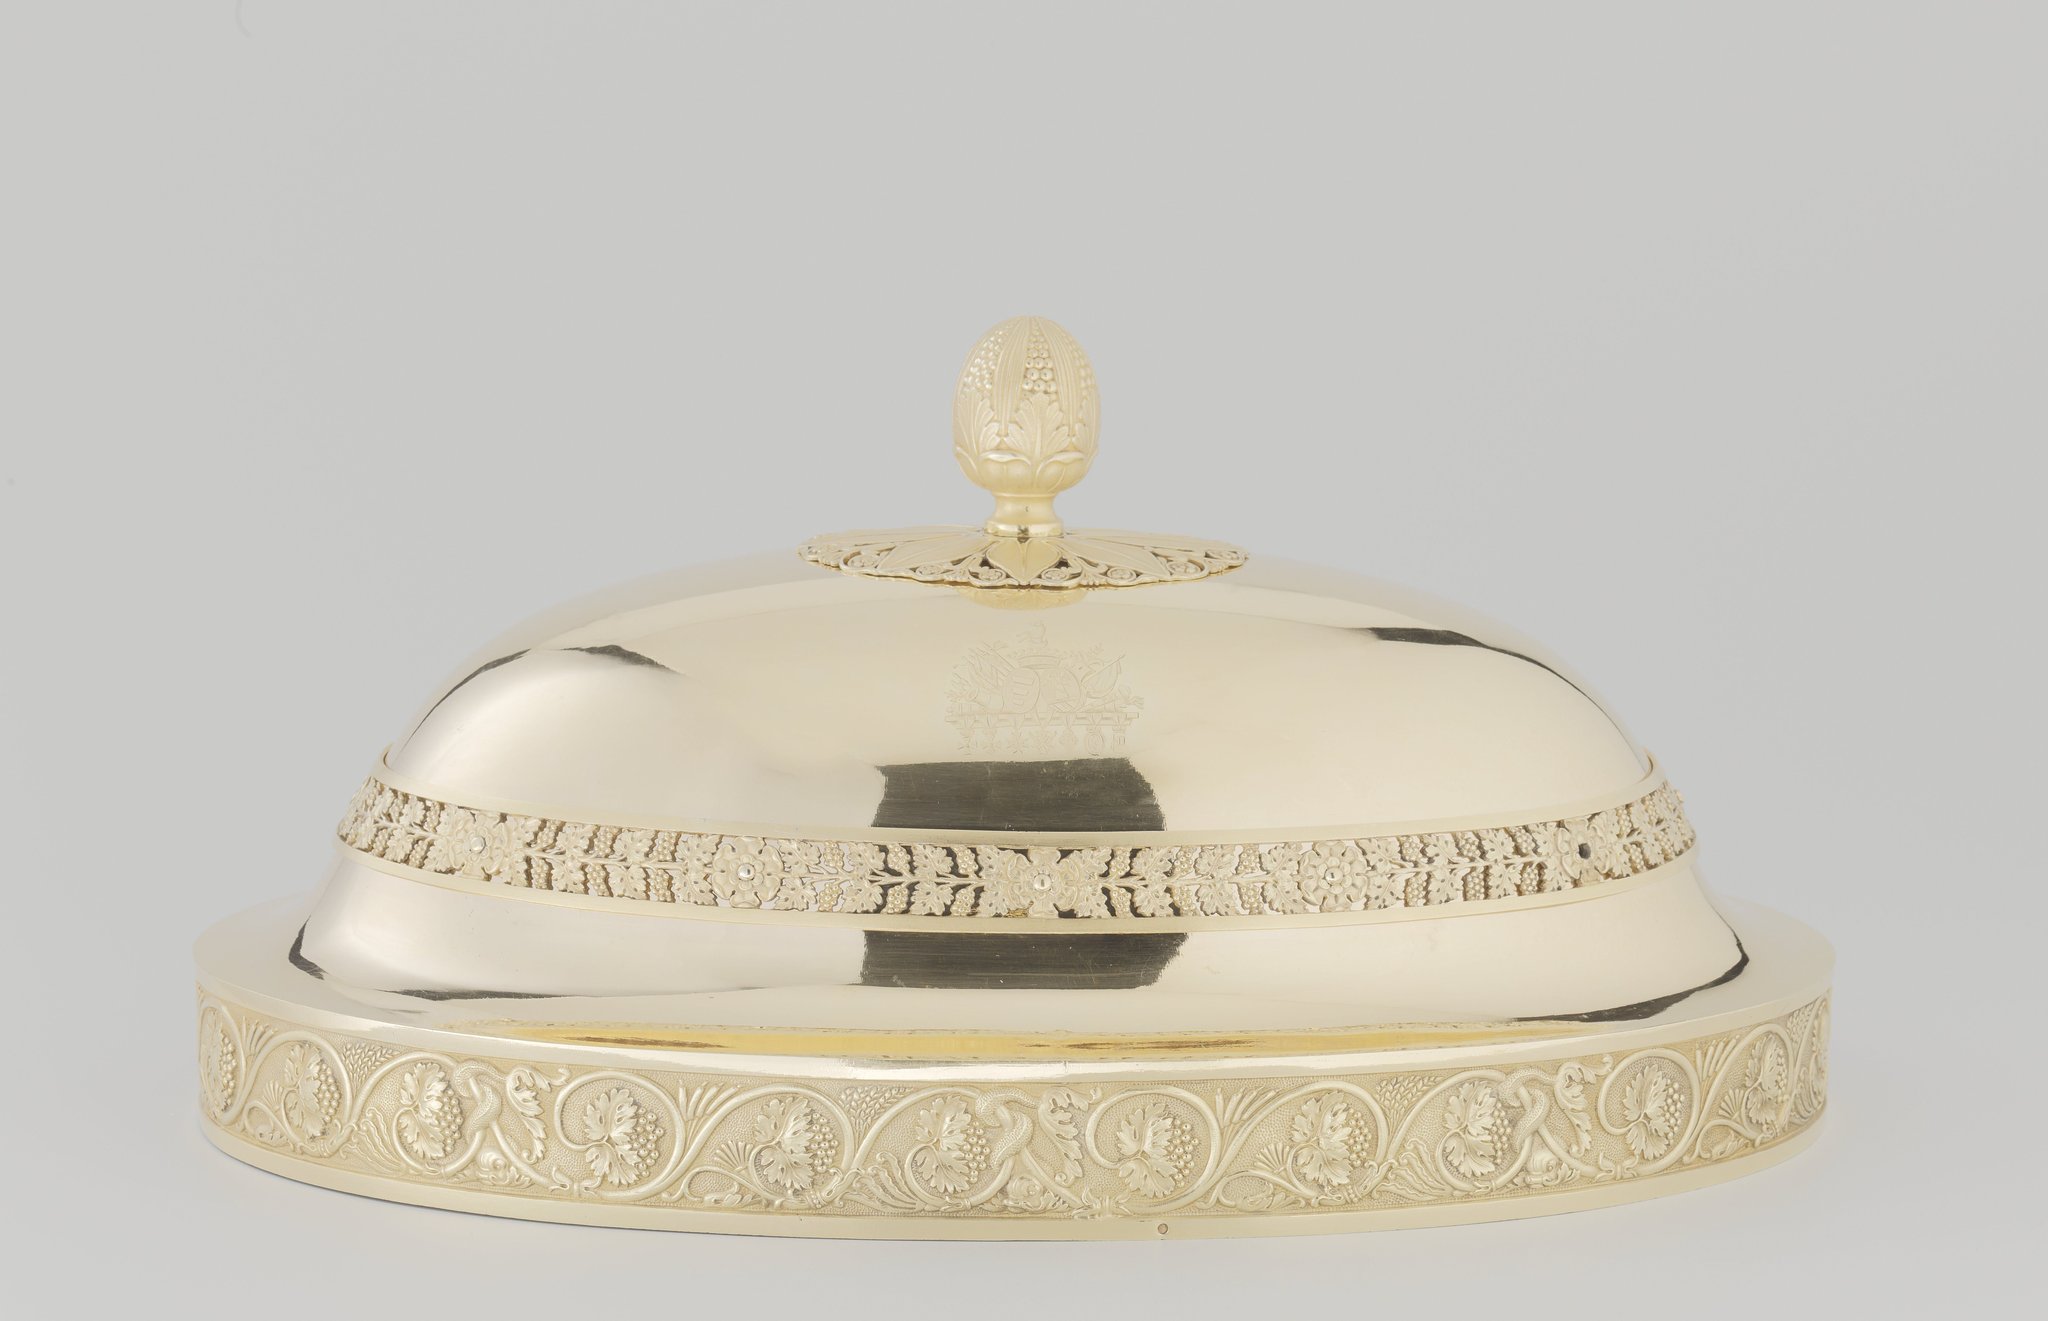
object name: lid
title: Dish covers, coolers, soup tureens, salt cellars, pepper and mustard pots, sauceboats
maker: jean baptiste claude odiot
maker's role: jeweler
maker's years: 1763-1850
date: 1819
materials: silver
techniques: gilding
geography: paris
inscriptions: maker's mark, duty mark, countermark, retailer's mark, alloy mark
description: These items are part of an 140-piece service that belonged to Alexandra Vasilievna Engelhardt, a noblewoman at the Russian court. The renowned silversmith Odiot collaborated with the painter Prud’hon and the architect Cavelier. They proudly presented their models at the French national crafts exhibition in 1819. The large late Empire figures, like the kneeling angels supporting the soup tureen, are striking.